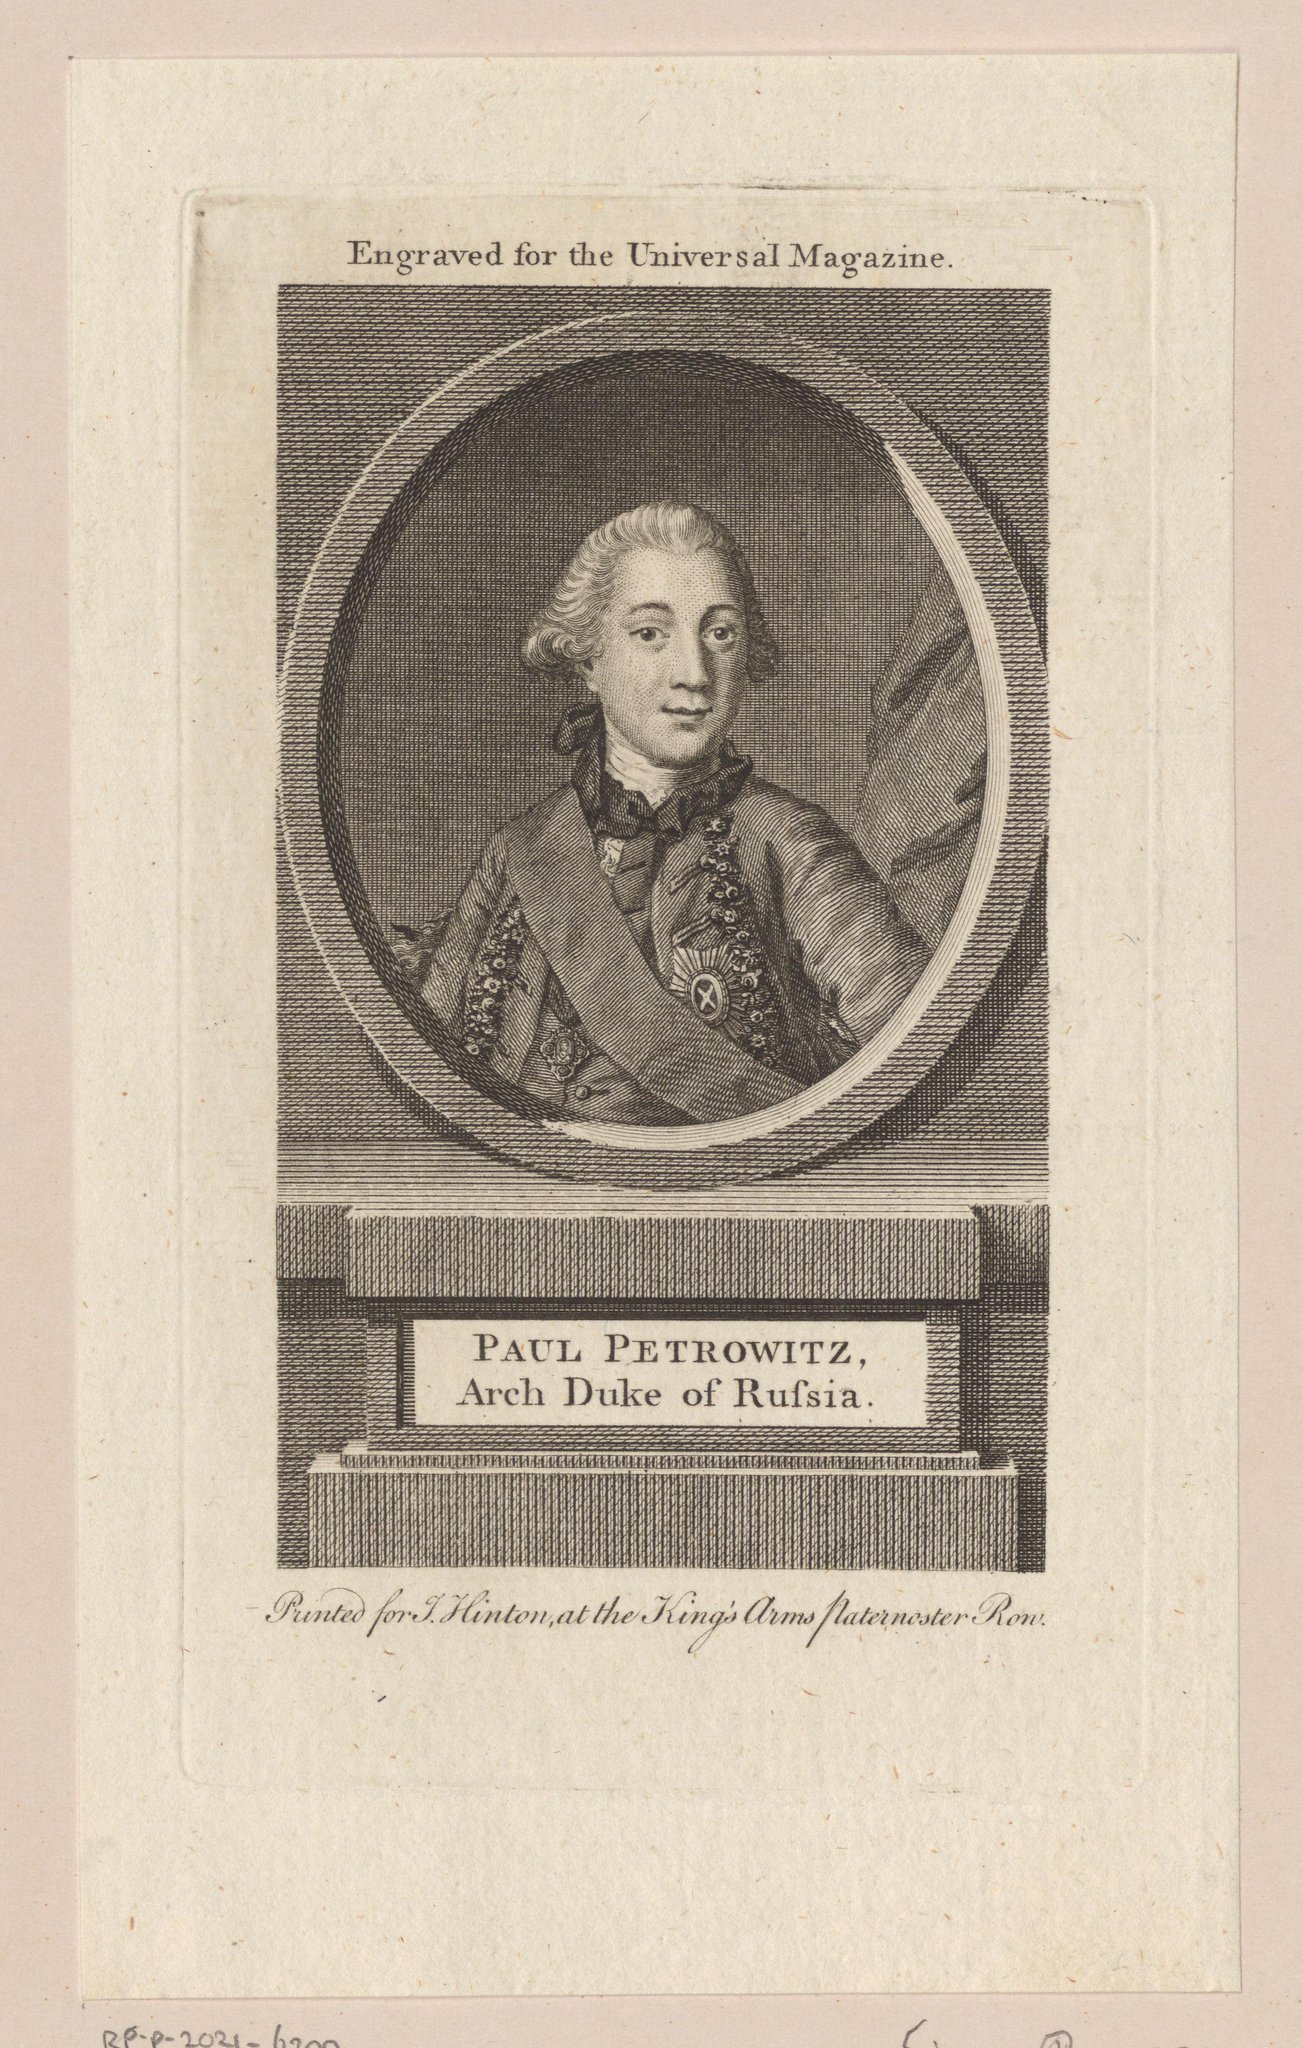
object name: print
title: Portret van Paul Petrovitsj, de latere Paul I, tsaar van Rusland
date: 1776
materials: paper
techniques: engraving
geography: london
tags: paul i (tsaar van rusland), adult man, historical persons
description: Prent uit: The Universal Magazine of Knowledge and Pleasure 59 (1776).